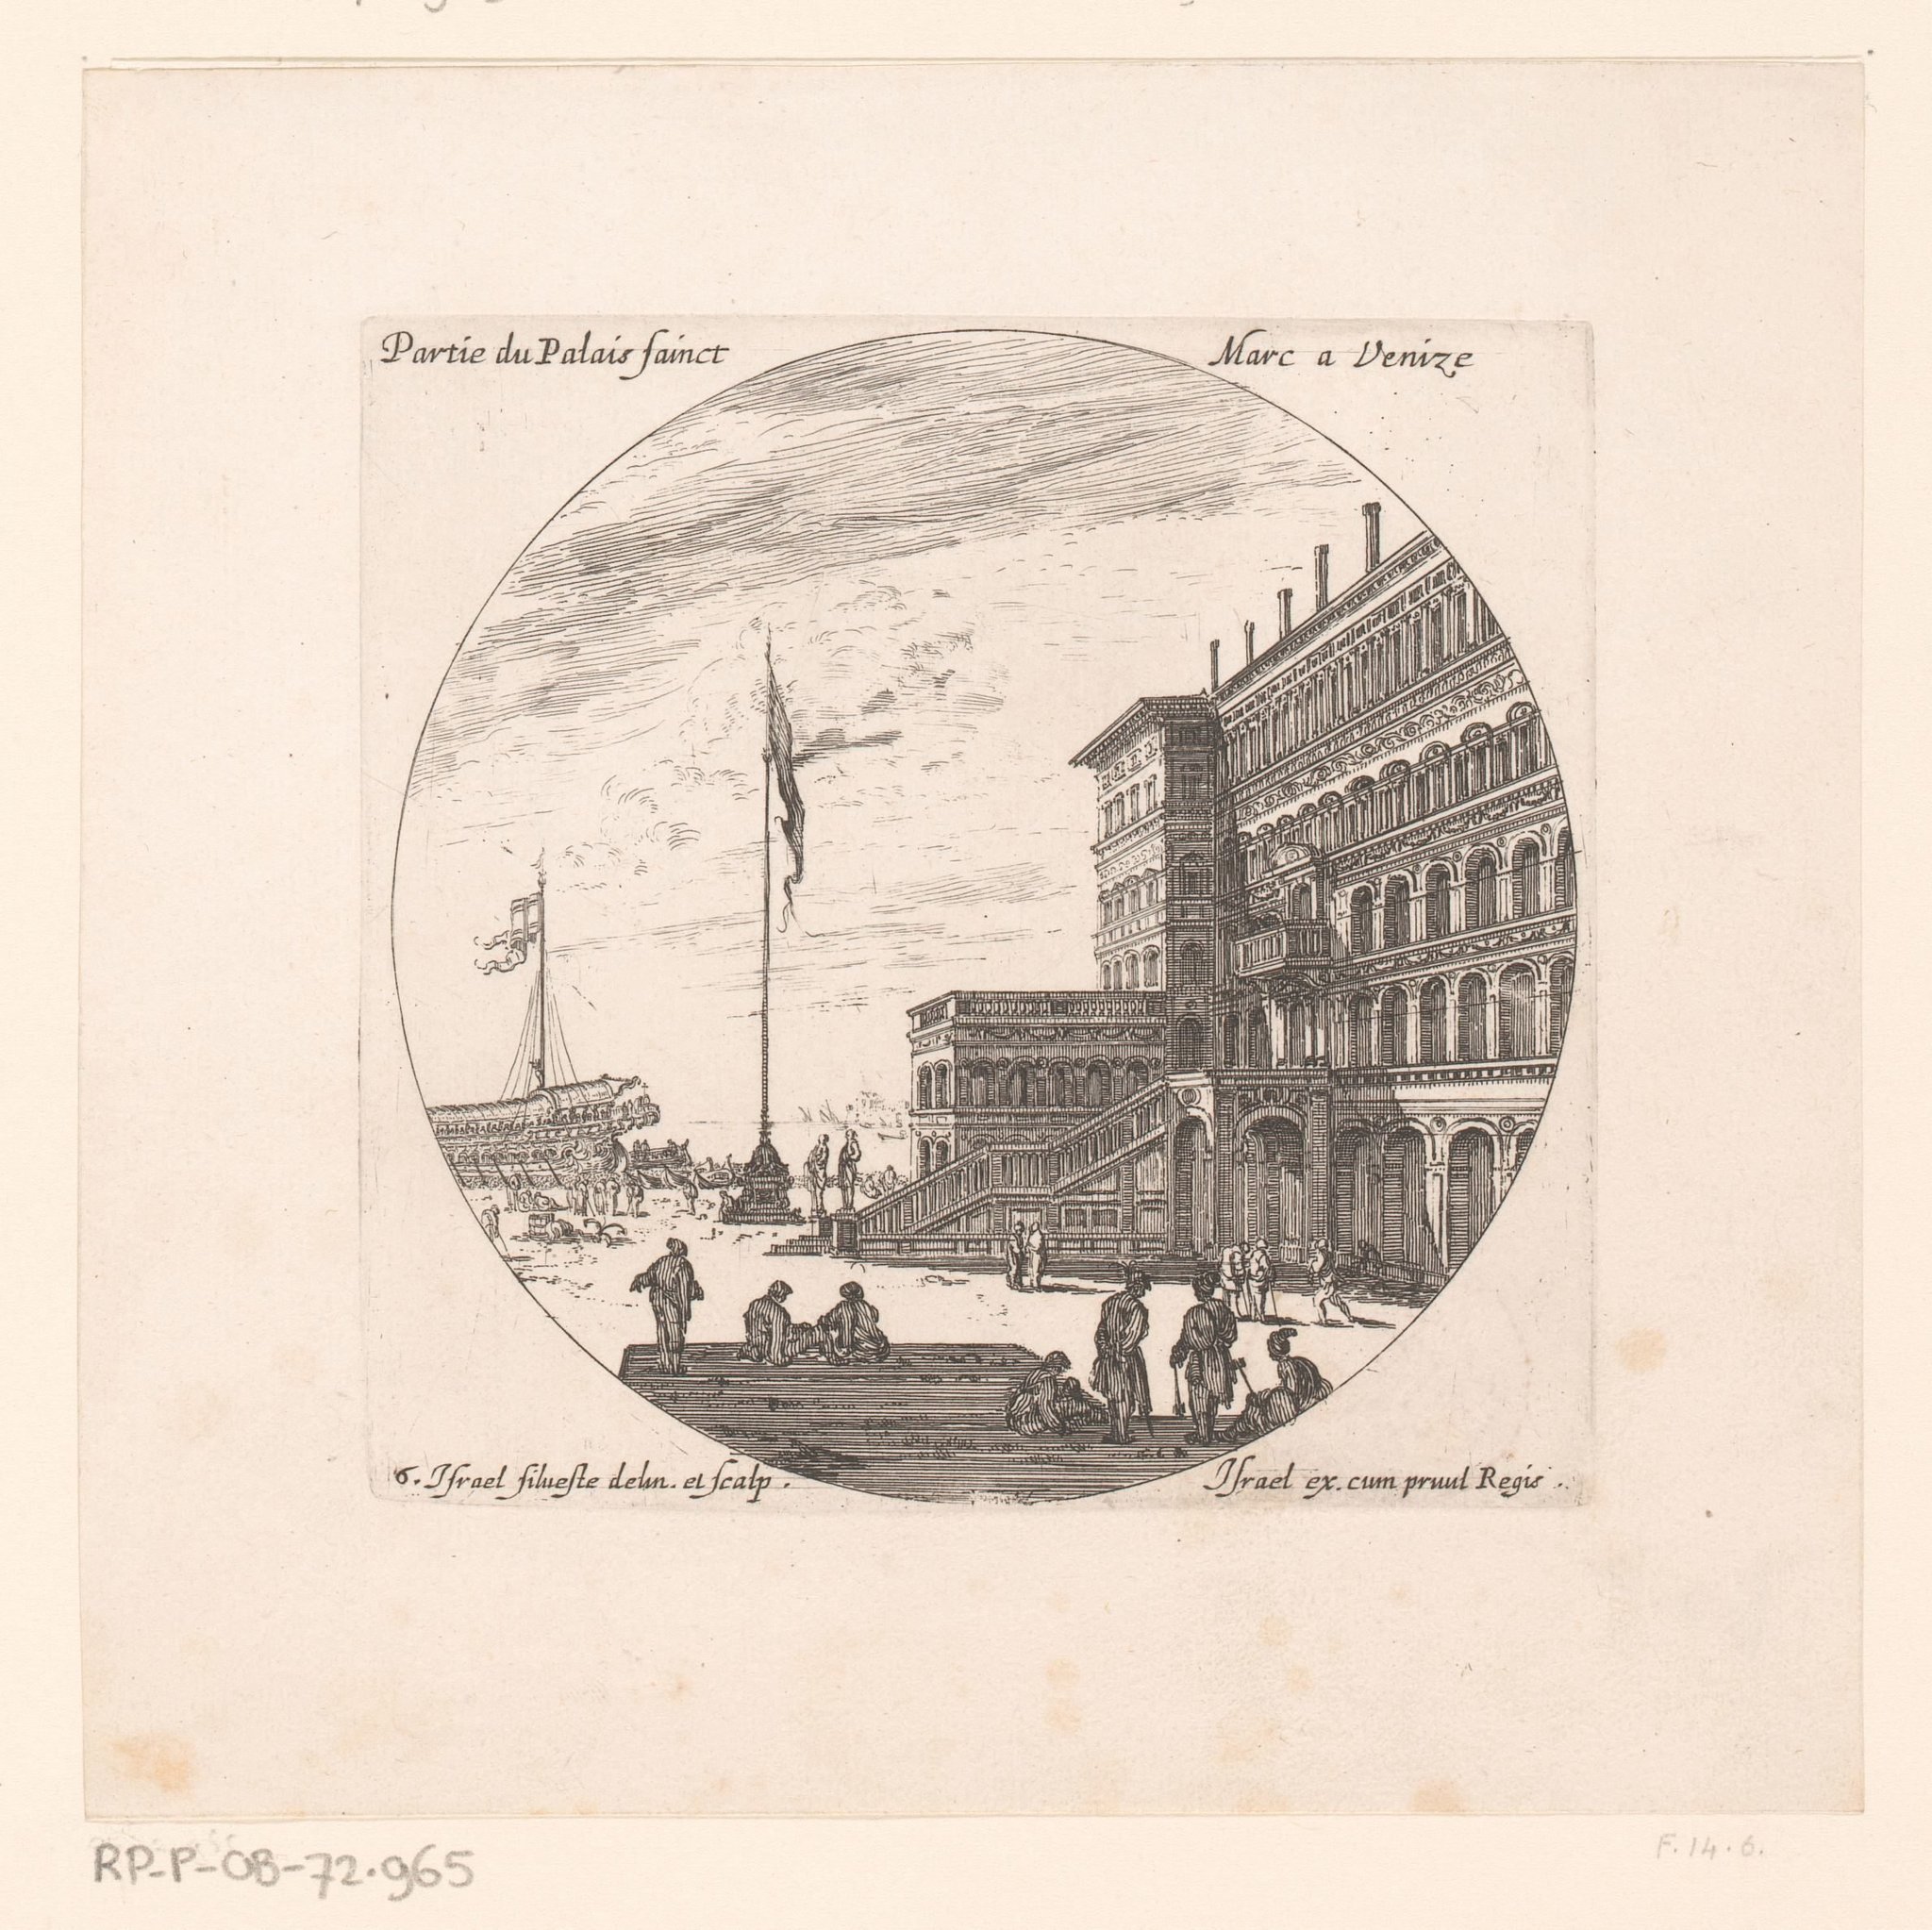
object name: print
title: Gezicht op het San Marcoplein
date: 1647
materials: paper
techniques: etching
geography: france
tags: harbour, city-view in general; 'veduta'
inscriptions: collector's mark: Lugt 240